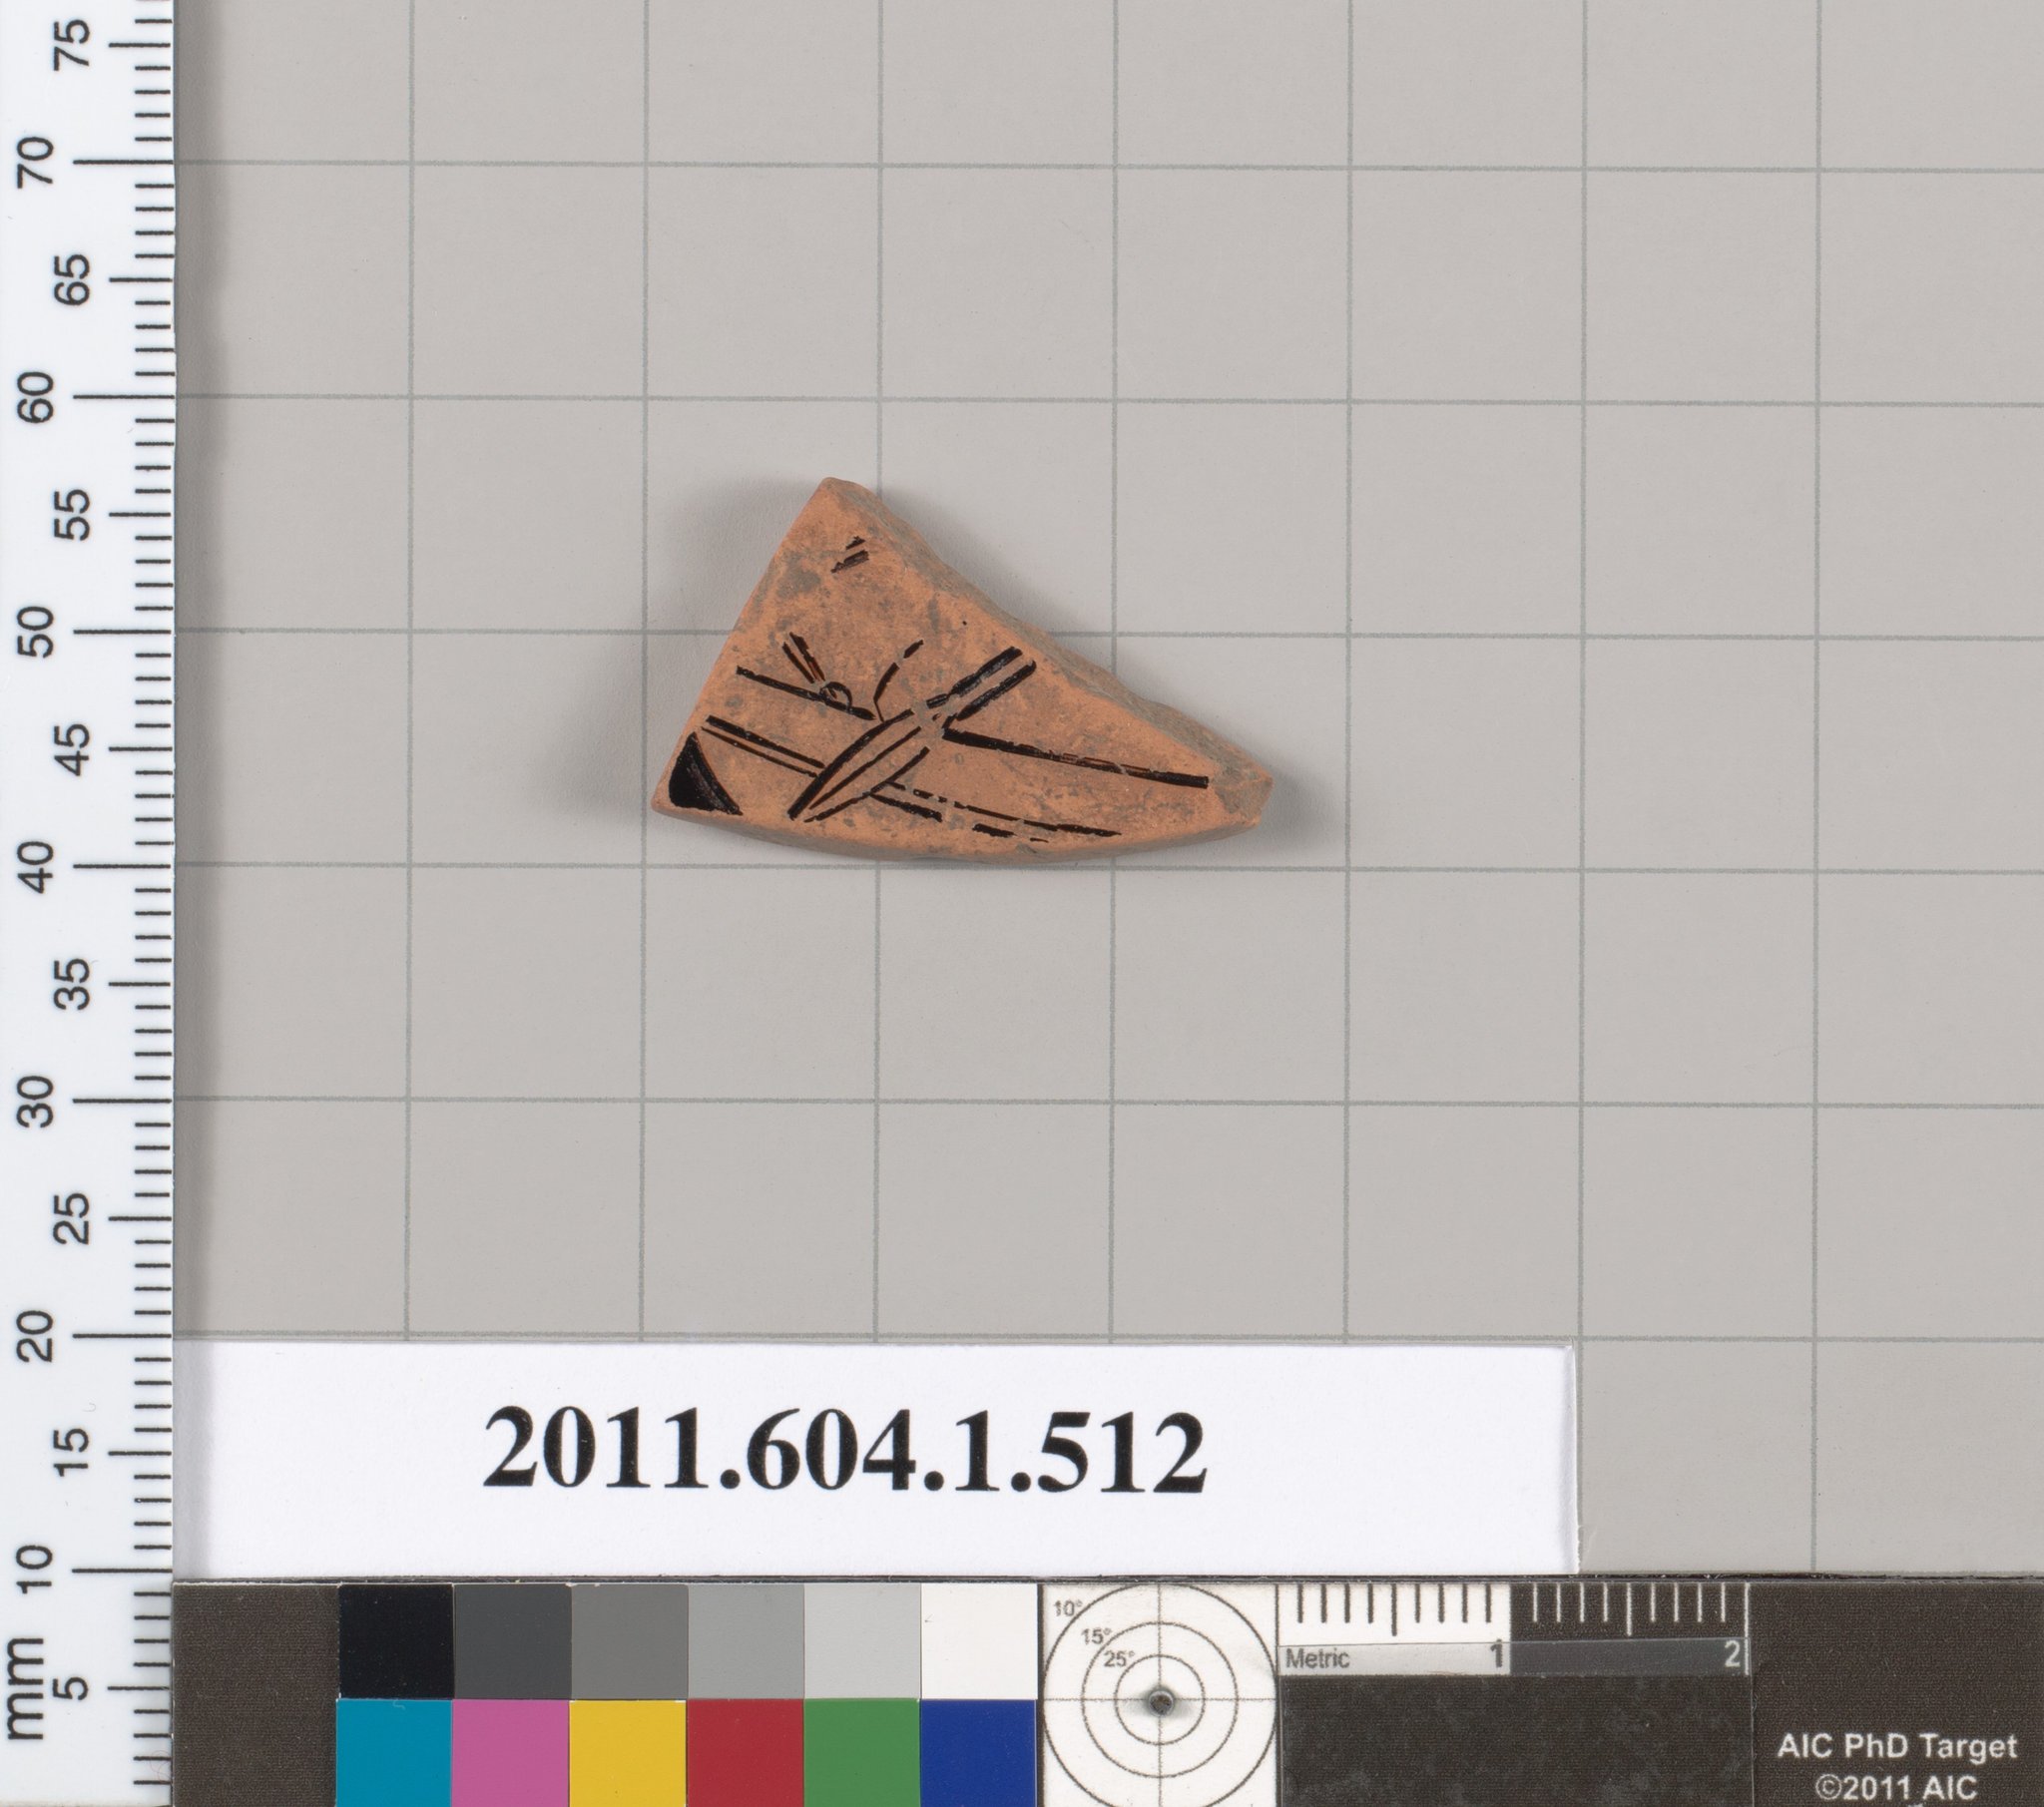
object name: kylix fragment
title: Terracotta fragment of a kylix (drinking cup)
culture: greek, attic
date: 500-476 BCE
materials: terracotta